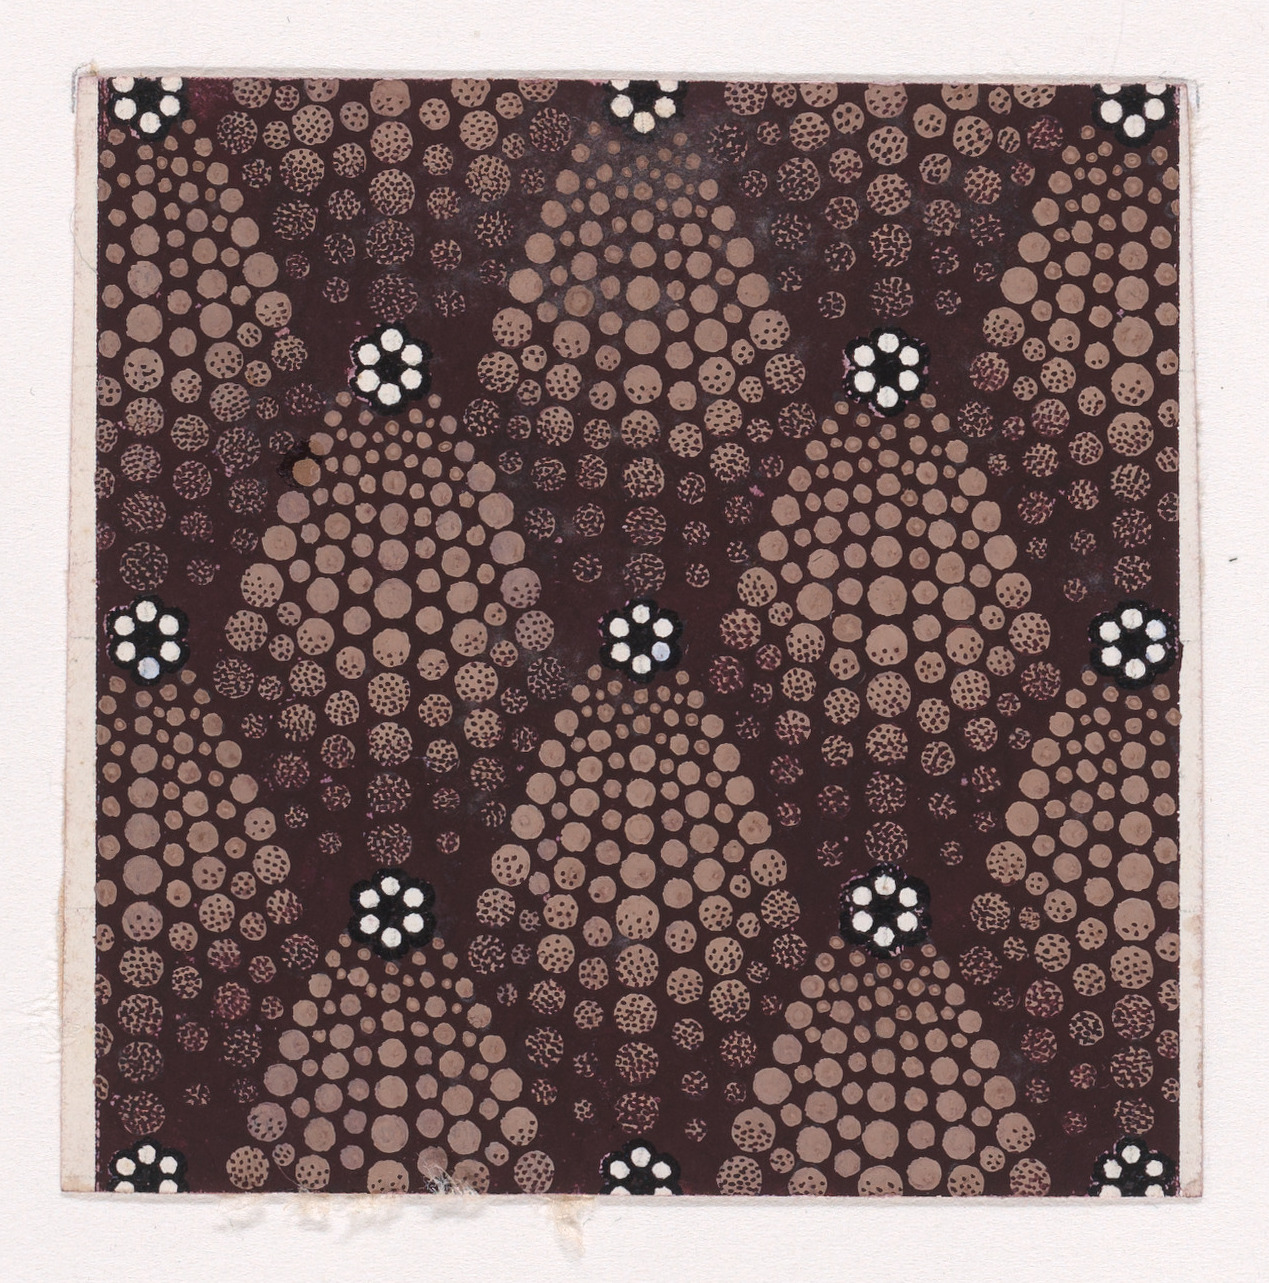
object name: drawing ornament architecture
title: Textile Design with Alternating Rosettes of Pearls Flanked with Abstract Palmettes of Dots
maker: anonymous, alsatian, 19th century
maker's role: artist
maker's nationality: alsatian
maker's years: 1800-1900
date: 1840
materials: gouache